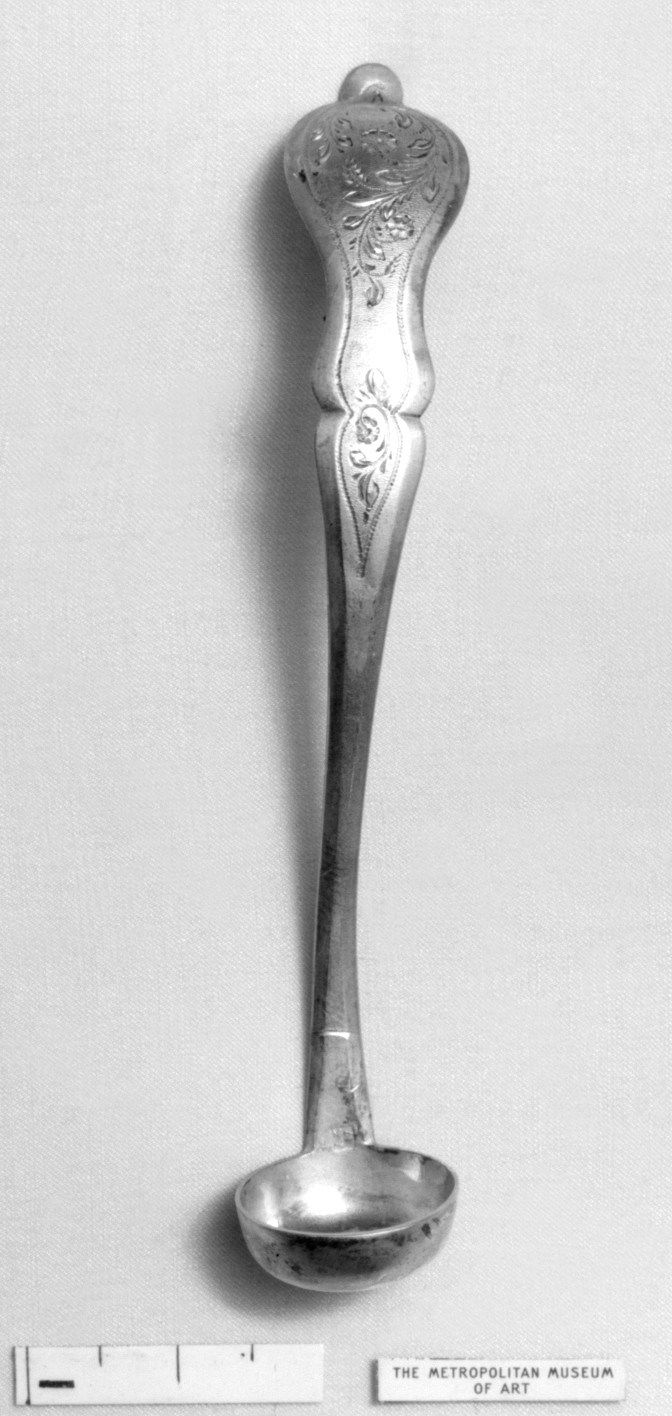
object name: mustard spoon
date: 1874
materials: gilt, silver